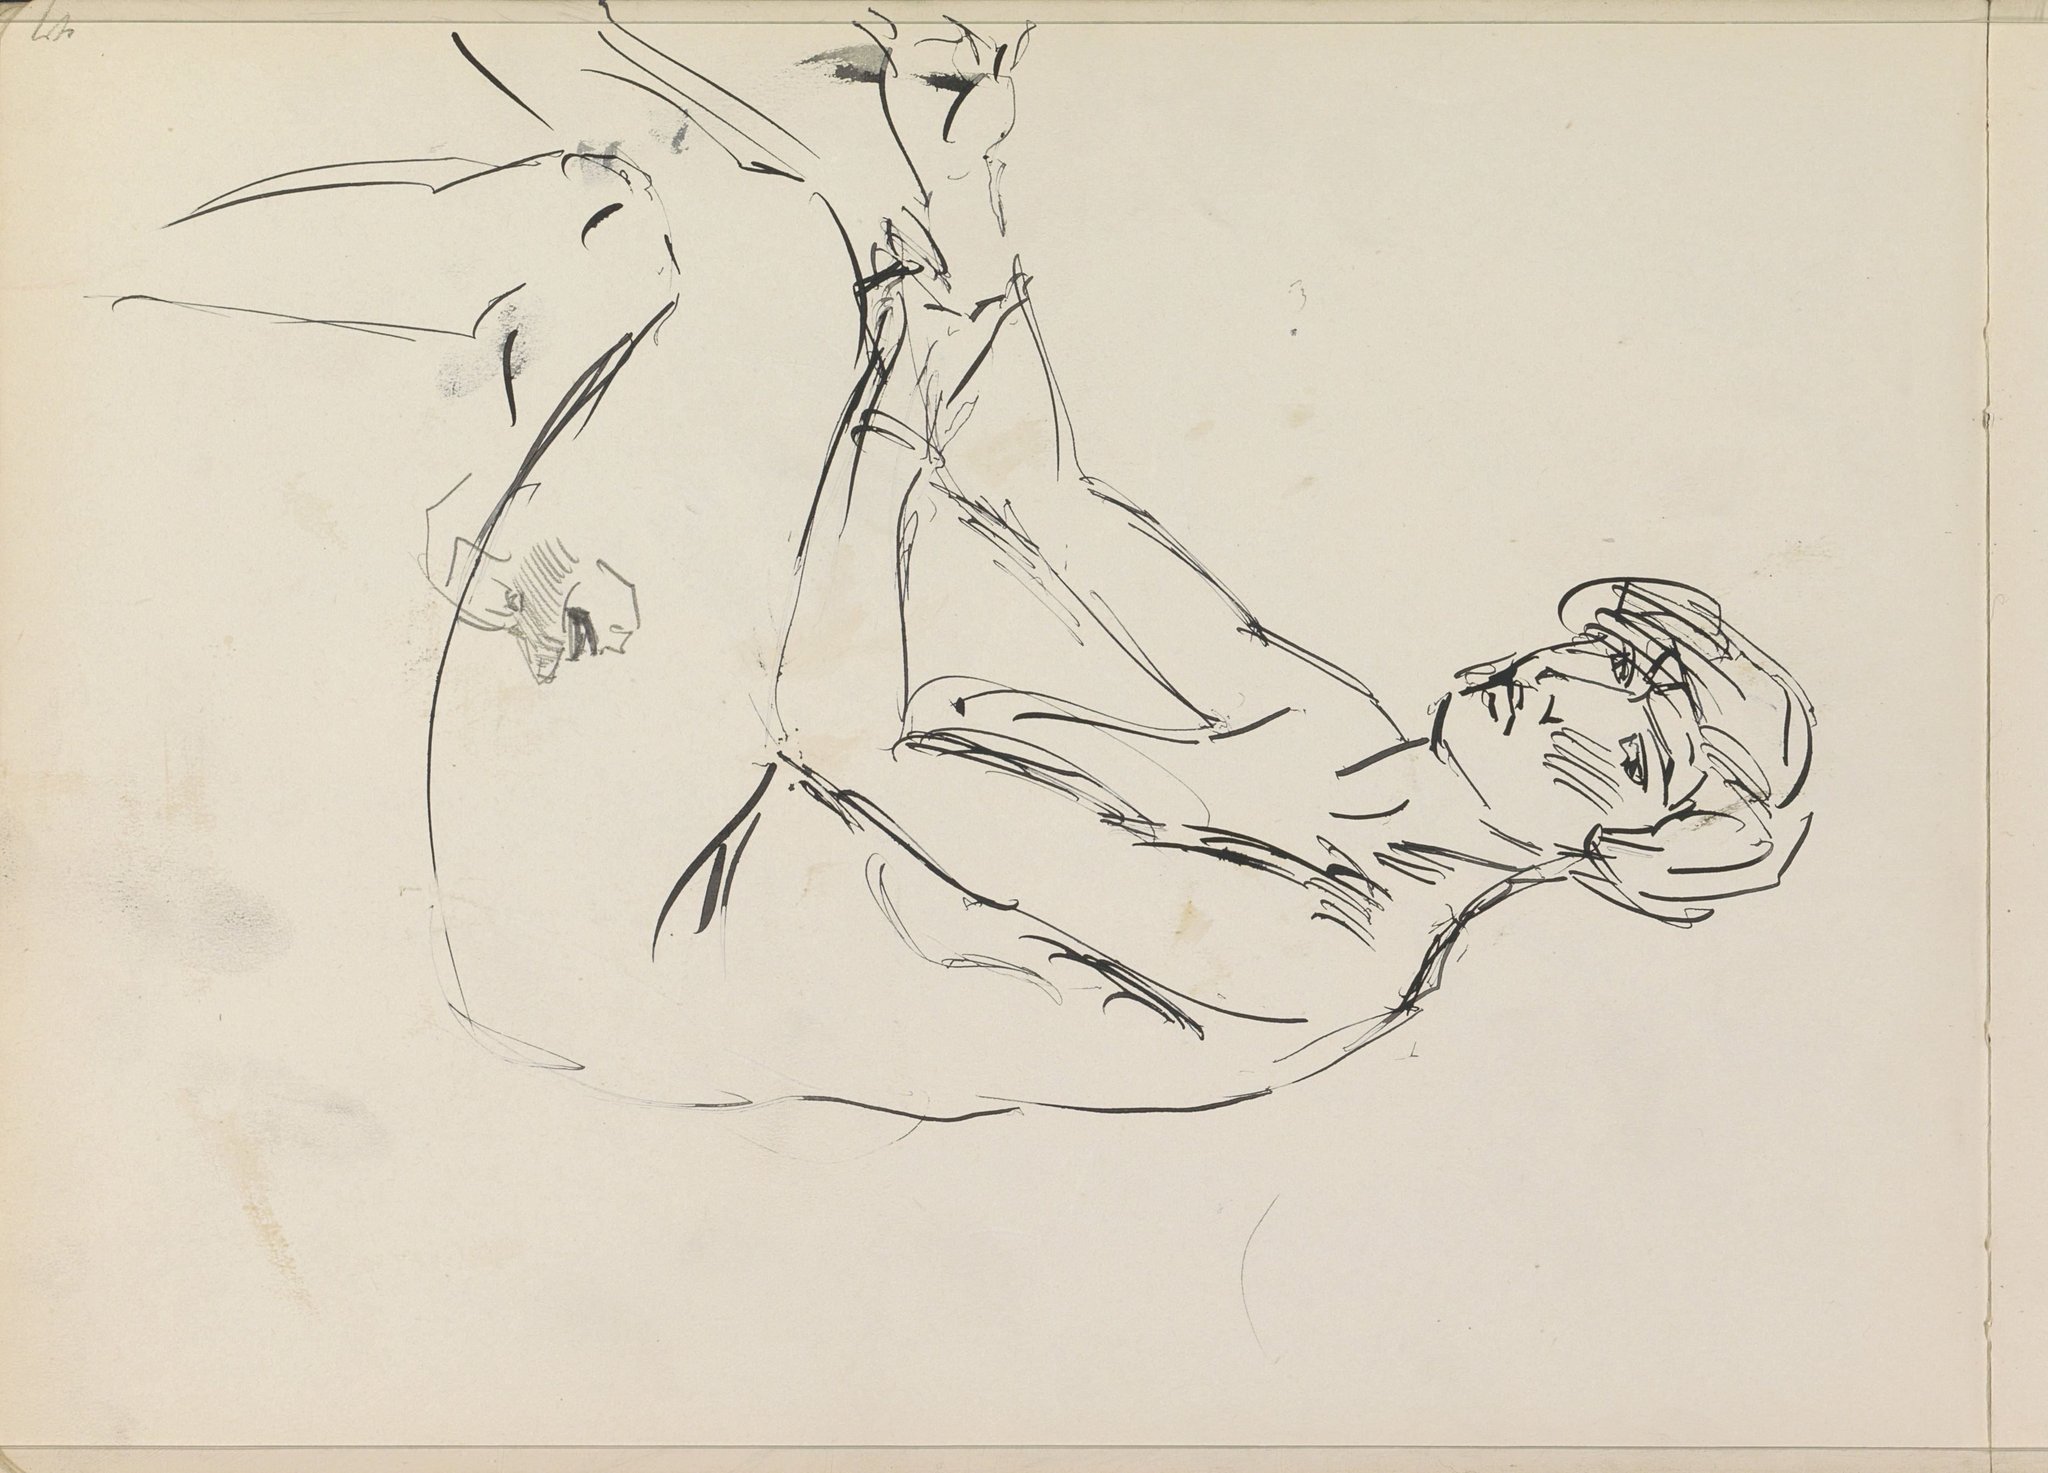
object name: sketchbook leaf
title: Zittend vrouwelijk naakt en een gezicht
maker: isaac israels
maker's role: draughtsman, painter, print maker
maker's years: 1865-1934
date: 1915-1934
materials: ink, paper, pencil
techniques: pen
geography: the hague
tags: face, sitting figure - aa - female human figure, clown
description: Mogelijk het gezicht van een clown. Blad 20 verso uit schetsboek VI met 33 bladen.